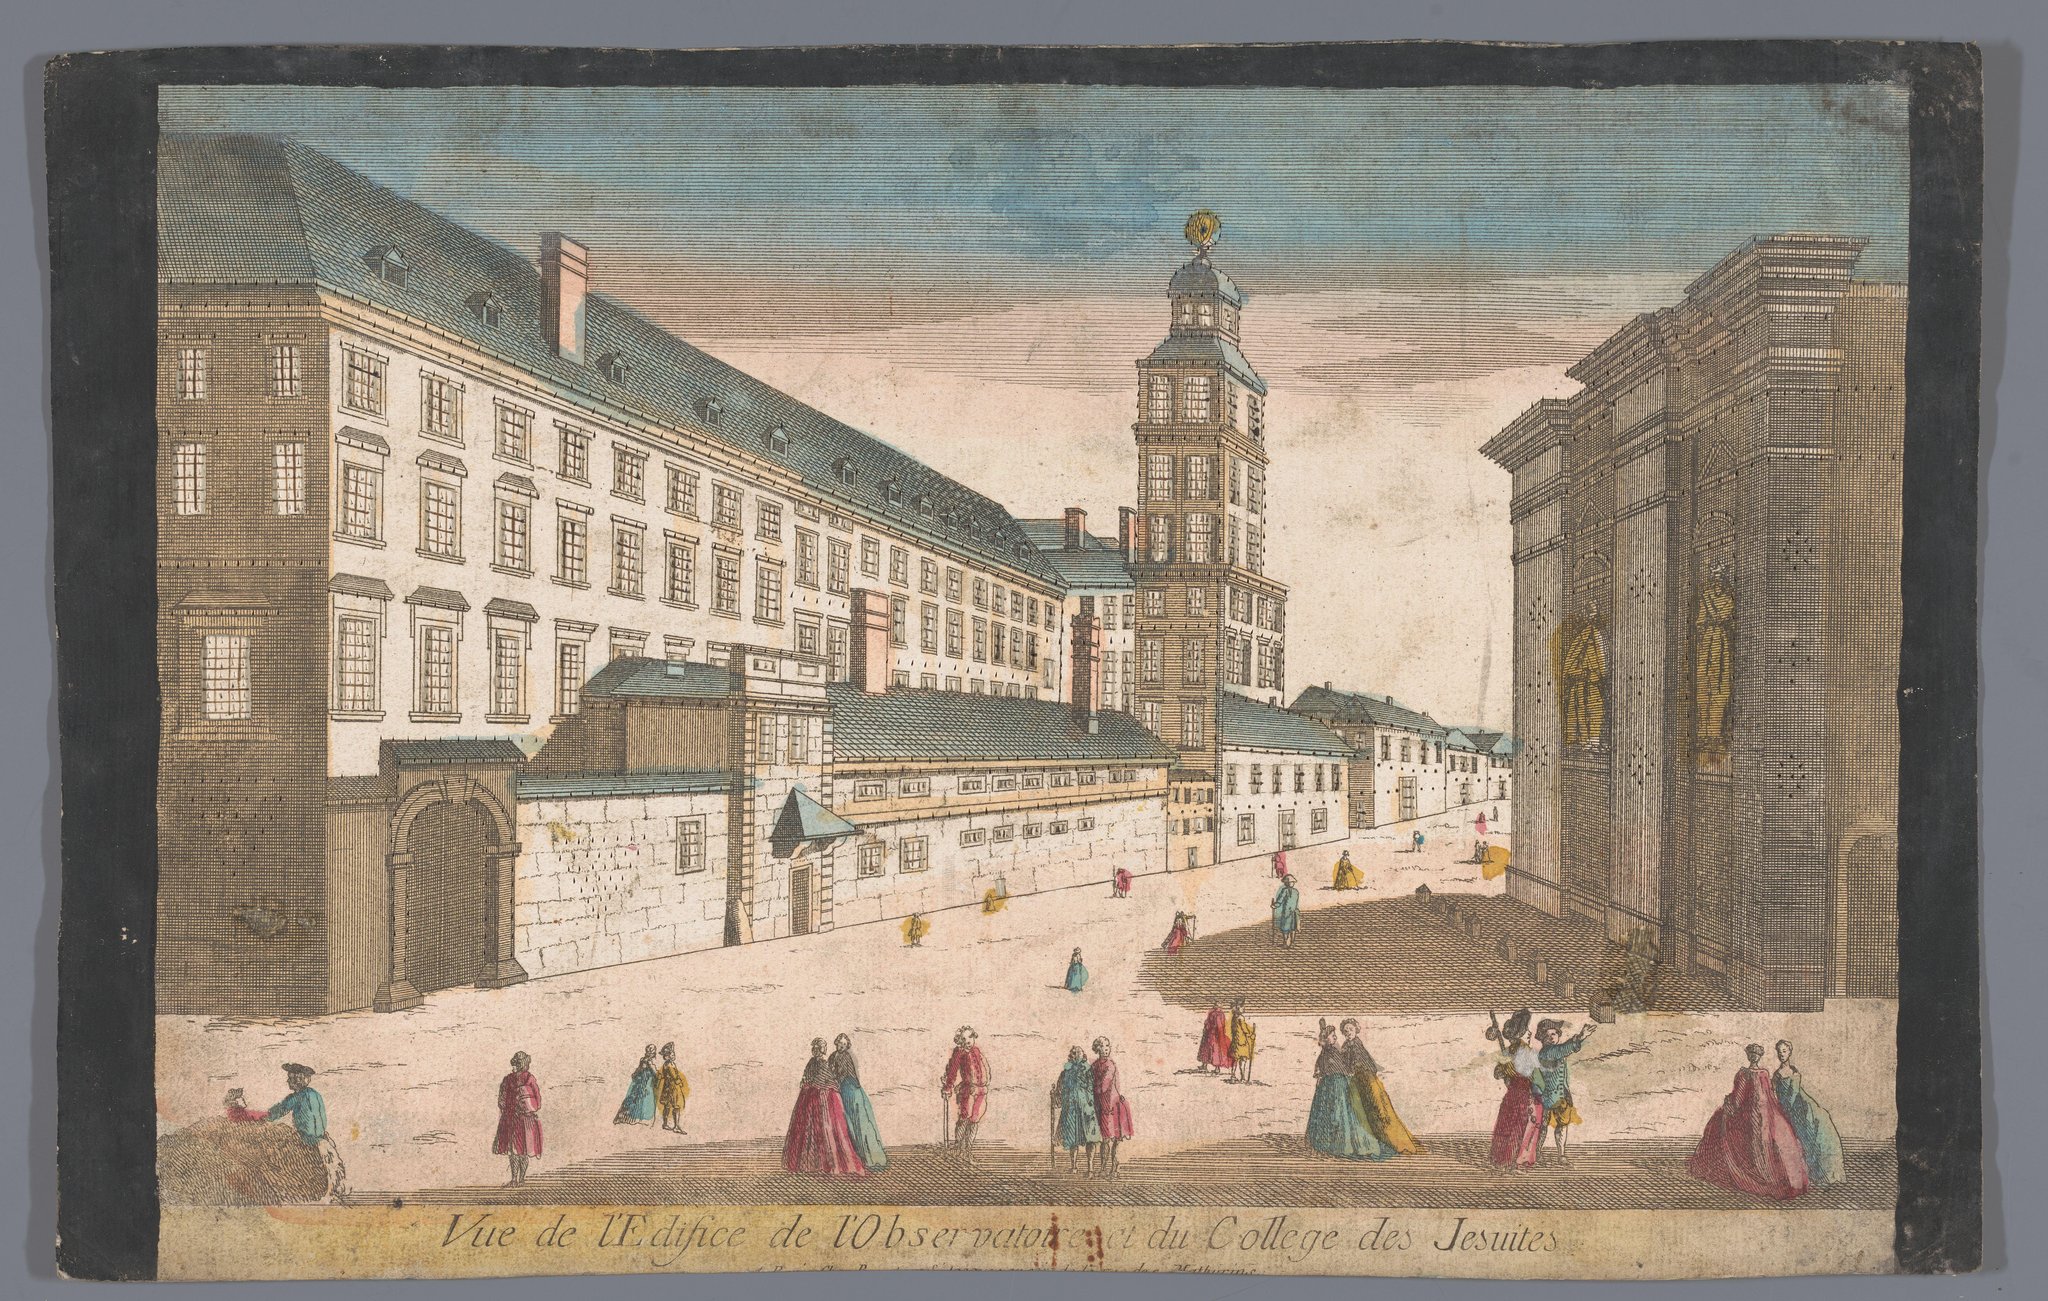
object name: opticaprent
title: Vue de l'Edifice de l'Observatoire et du College des Jesuits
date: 1700-1799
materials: cardboard, paint, paper, watercolor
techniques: brush, cutting, etching, perforating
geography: france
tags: meteorological observatory, regular clerics, e.g. jesuits, redemptorists, rome